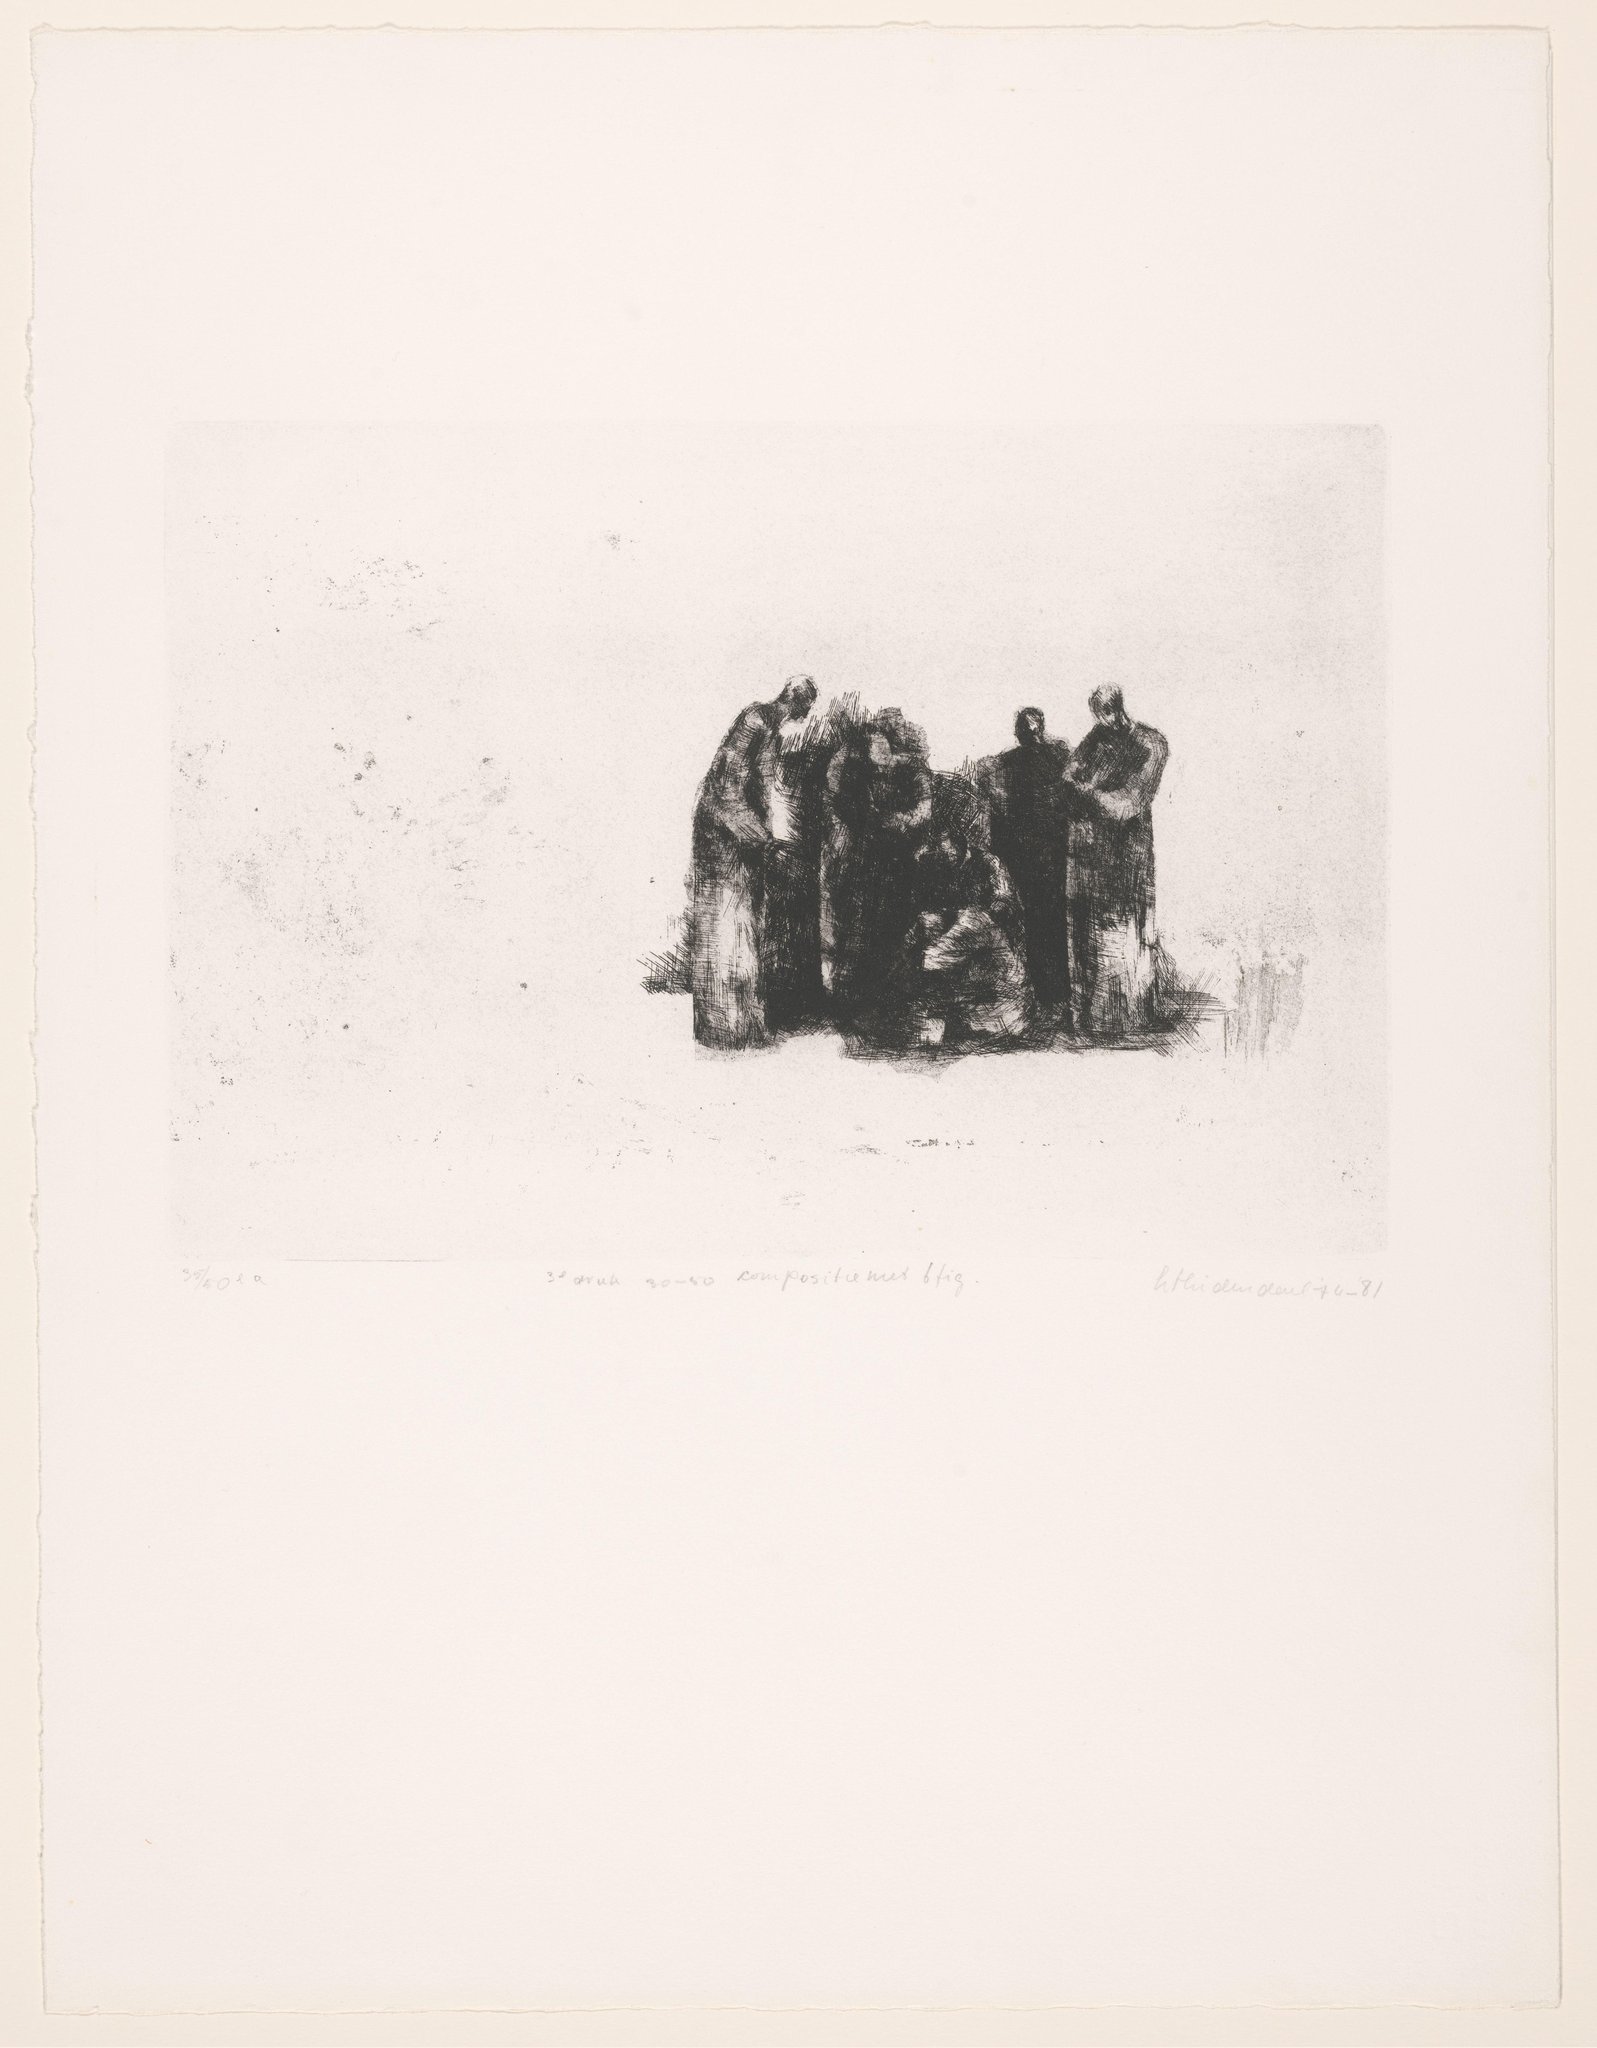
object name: print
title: Compositie met zes figuren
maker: lau heidendael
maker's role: print maker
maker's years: 1946-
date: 1976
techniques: etching